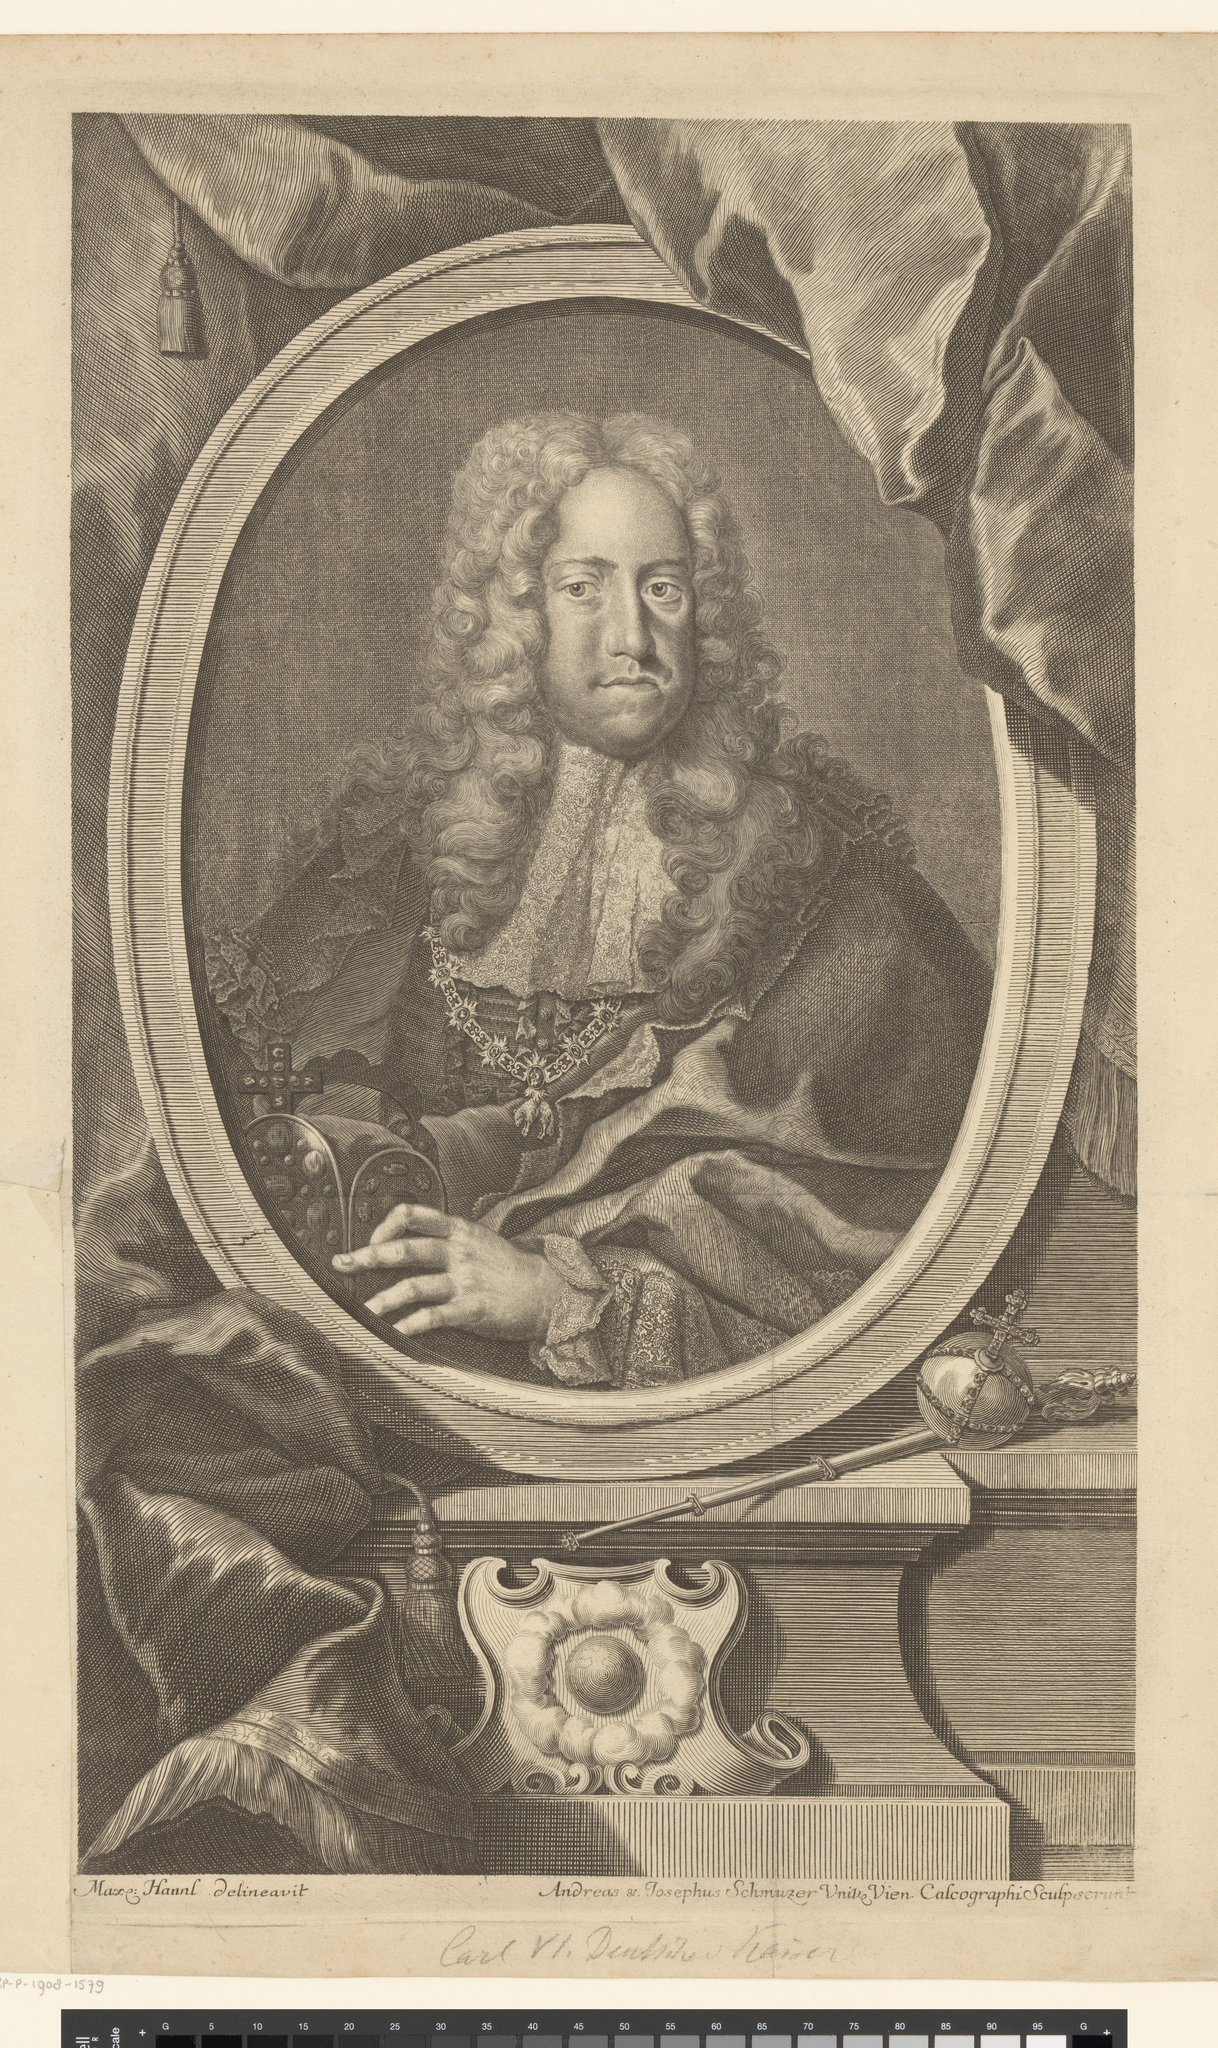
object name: print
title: Portret van keizer Karel VI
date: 1710-1740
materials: paper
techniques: engraving, etching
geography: vienna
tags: vienna, charles vi (holy roman emperor), historical persons, knighthood order of the golden fleece - insignia of a knighthood order, e.g.: badge, chain (with name of order), insignia and symbols of sovereignty (crown, diadem, sceptre, orb, seal, standard, cloak, pectoral)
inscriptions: collector's mark: Lugt 2228